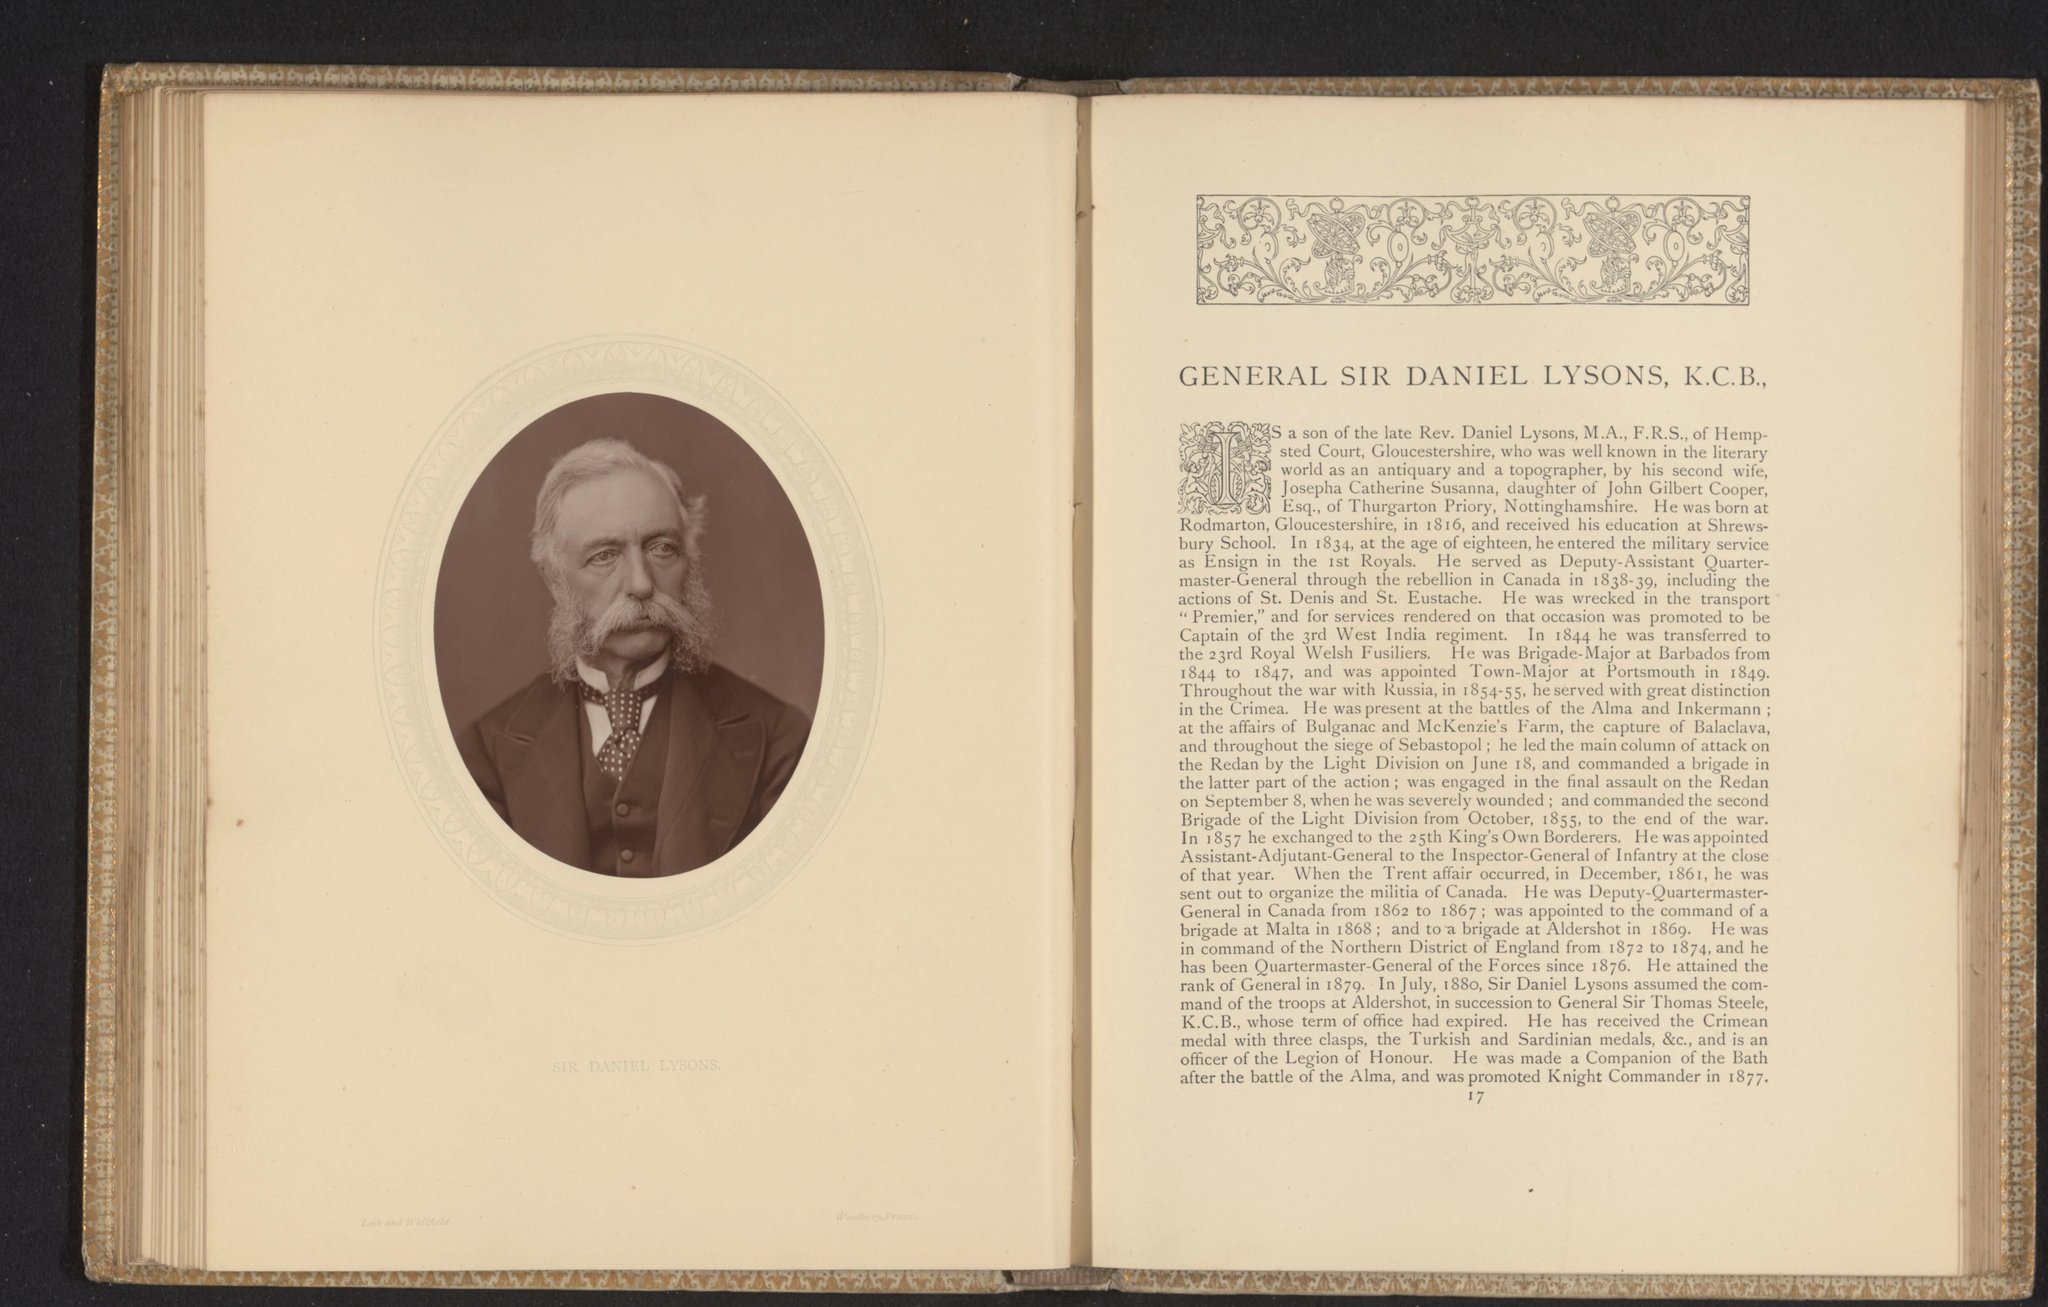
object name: photomechanical print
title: Sir Daniel Lysons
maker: Anonymous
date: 1877-1882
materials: paper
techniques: woodburytype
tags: commander-in-chief, general, marshal, historical persons (portraits and scenes from the life) (+ (full) bust portrait)